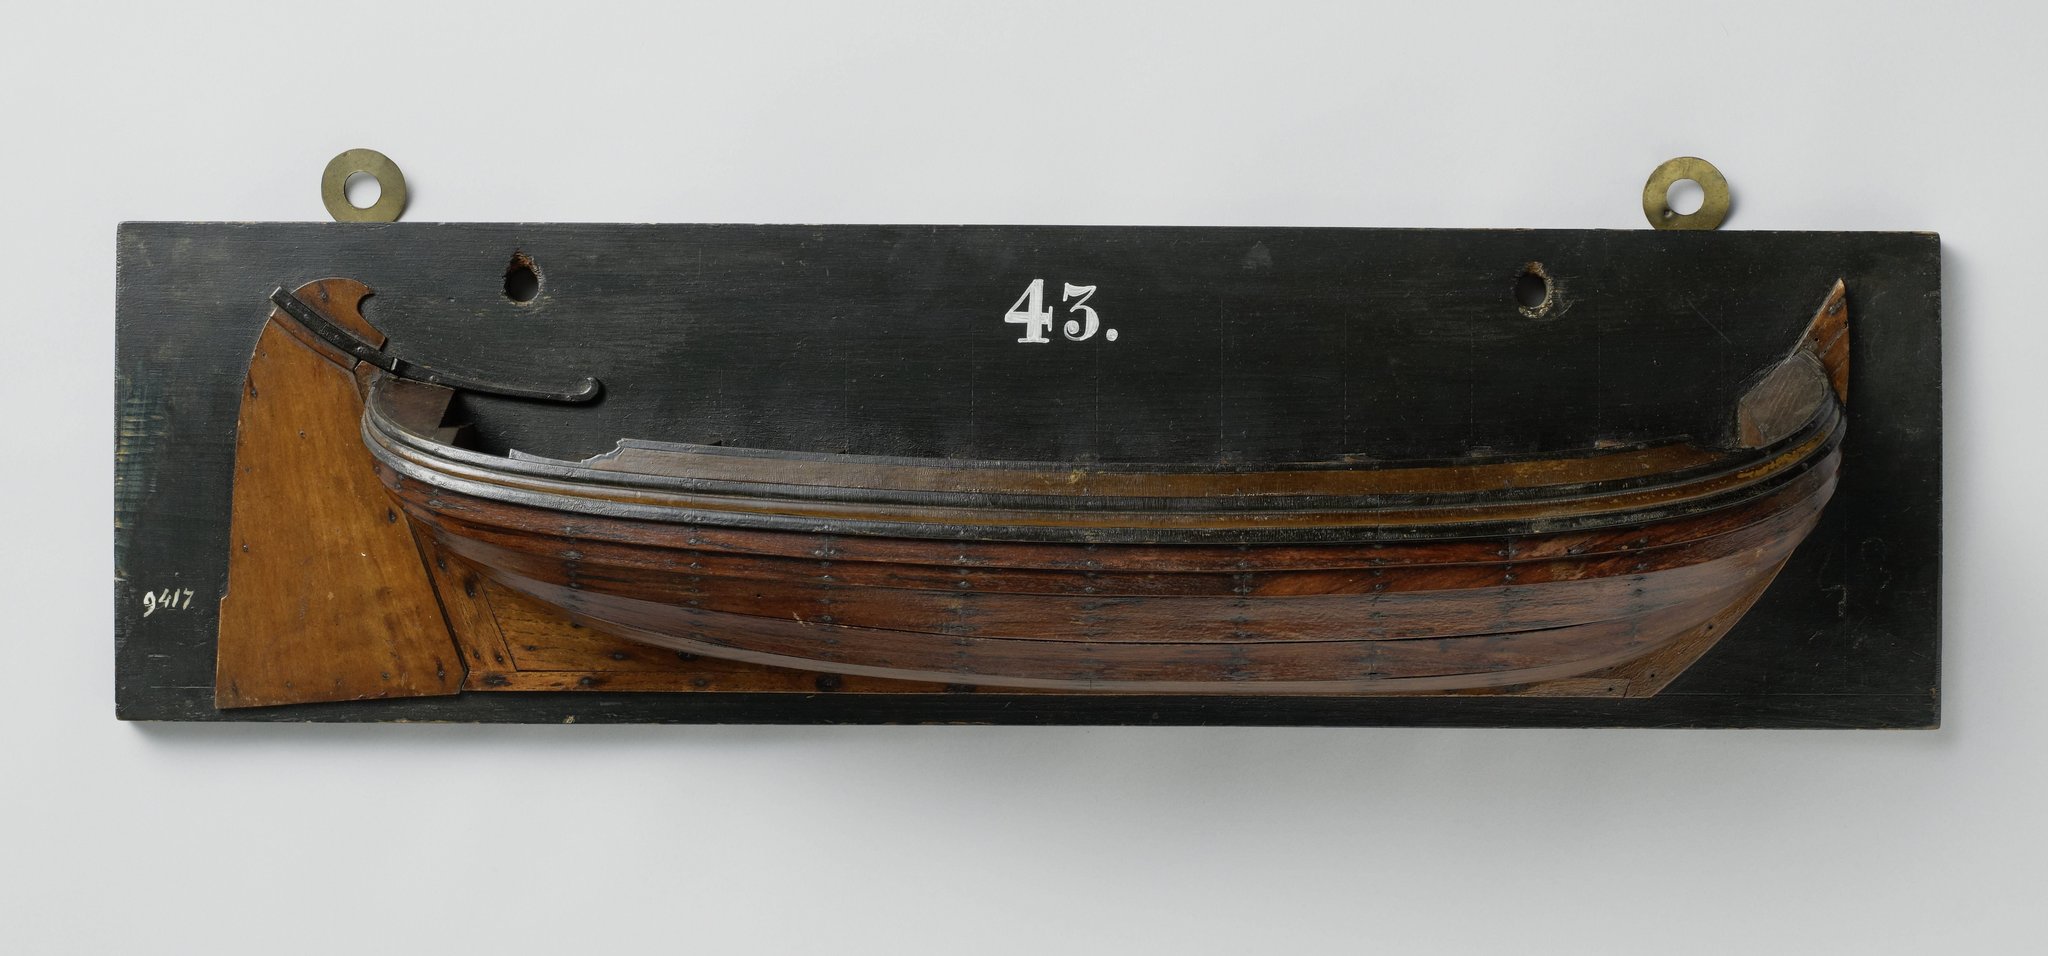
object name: half model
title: Half Model of a Boyer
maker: Anonymous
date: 1400-1950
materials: wood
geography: netherlands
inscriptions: number: ‘43.’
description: Rond voorschip. Voorsteven bol boven het einde verticaal. Boegronding is rond. Voorschip is vrij hoog oplopend en naar de zijden schuin aflopend. Rond achterschip met vallend achtersteven (2/5 cm). Een recht roer over boord met helmstok en zeer breed blad dat aan de onderzijde schuin dieper steekt dan de kiel. De bodem heeft een zwakke v-vorm, voor en achter rond oplopend. Het berghout bestaat uit drie smalle gangen dikker dan de huidgangen, lopend van de achtersteven tot op de voorsteven. Deze drie gangen zijn niet overnaads aangebracht zoals de andere gangen van de huid (deels). Een zeeg voor en achter oplopend. De huid is geheel gesloten met brede huidgangen. De derde en vierde huidgang overnaads aangegeven bij het voor- en achterschip. De vijfde en zesde huidgang geheel overnaads. Boven het berghout een gesloten boord aangegeven over een lengte van 43 cm. Model is gemonteerd op een plank.